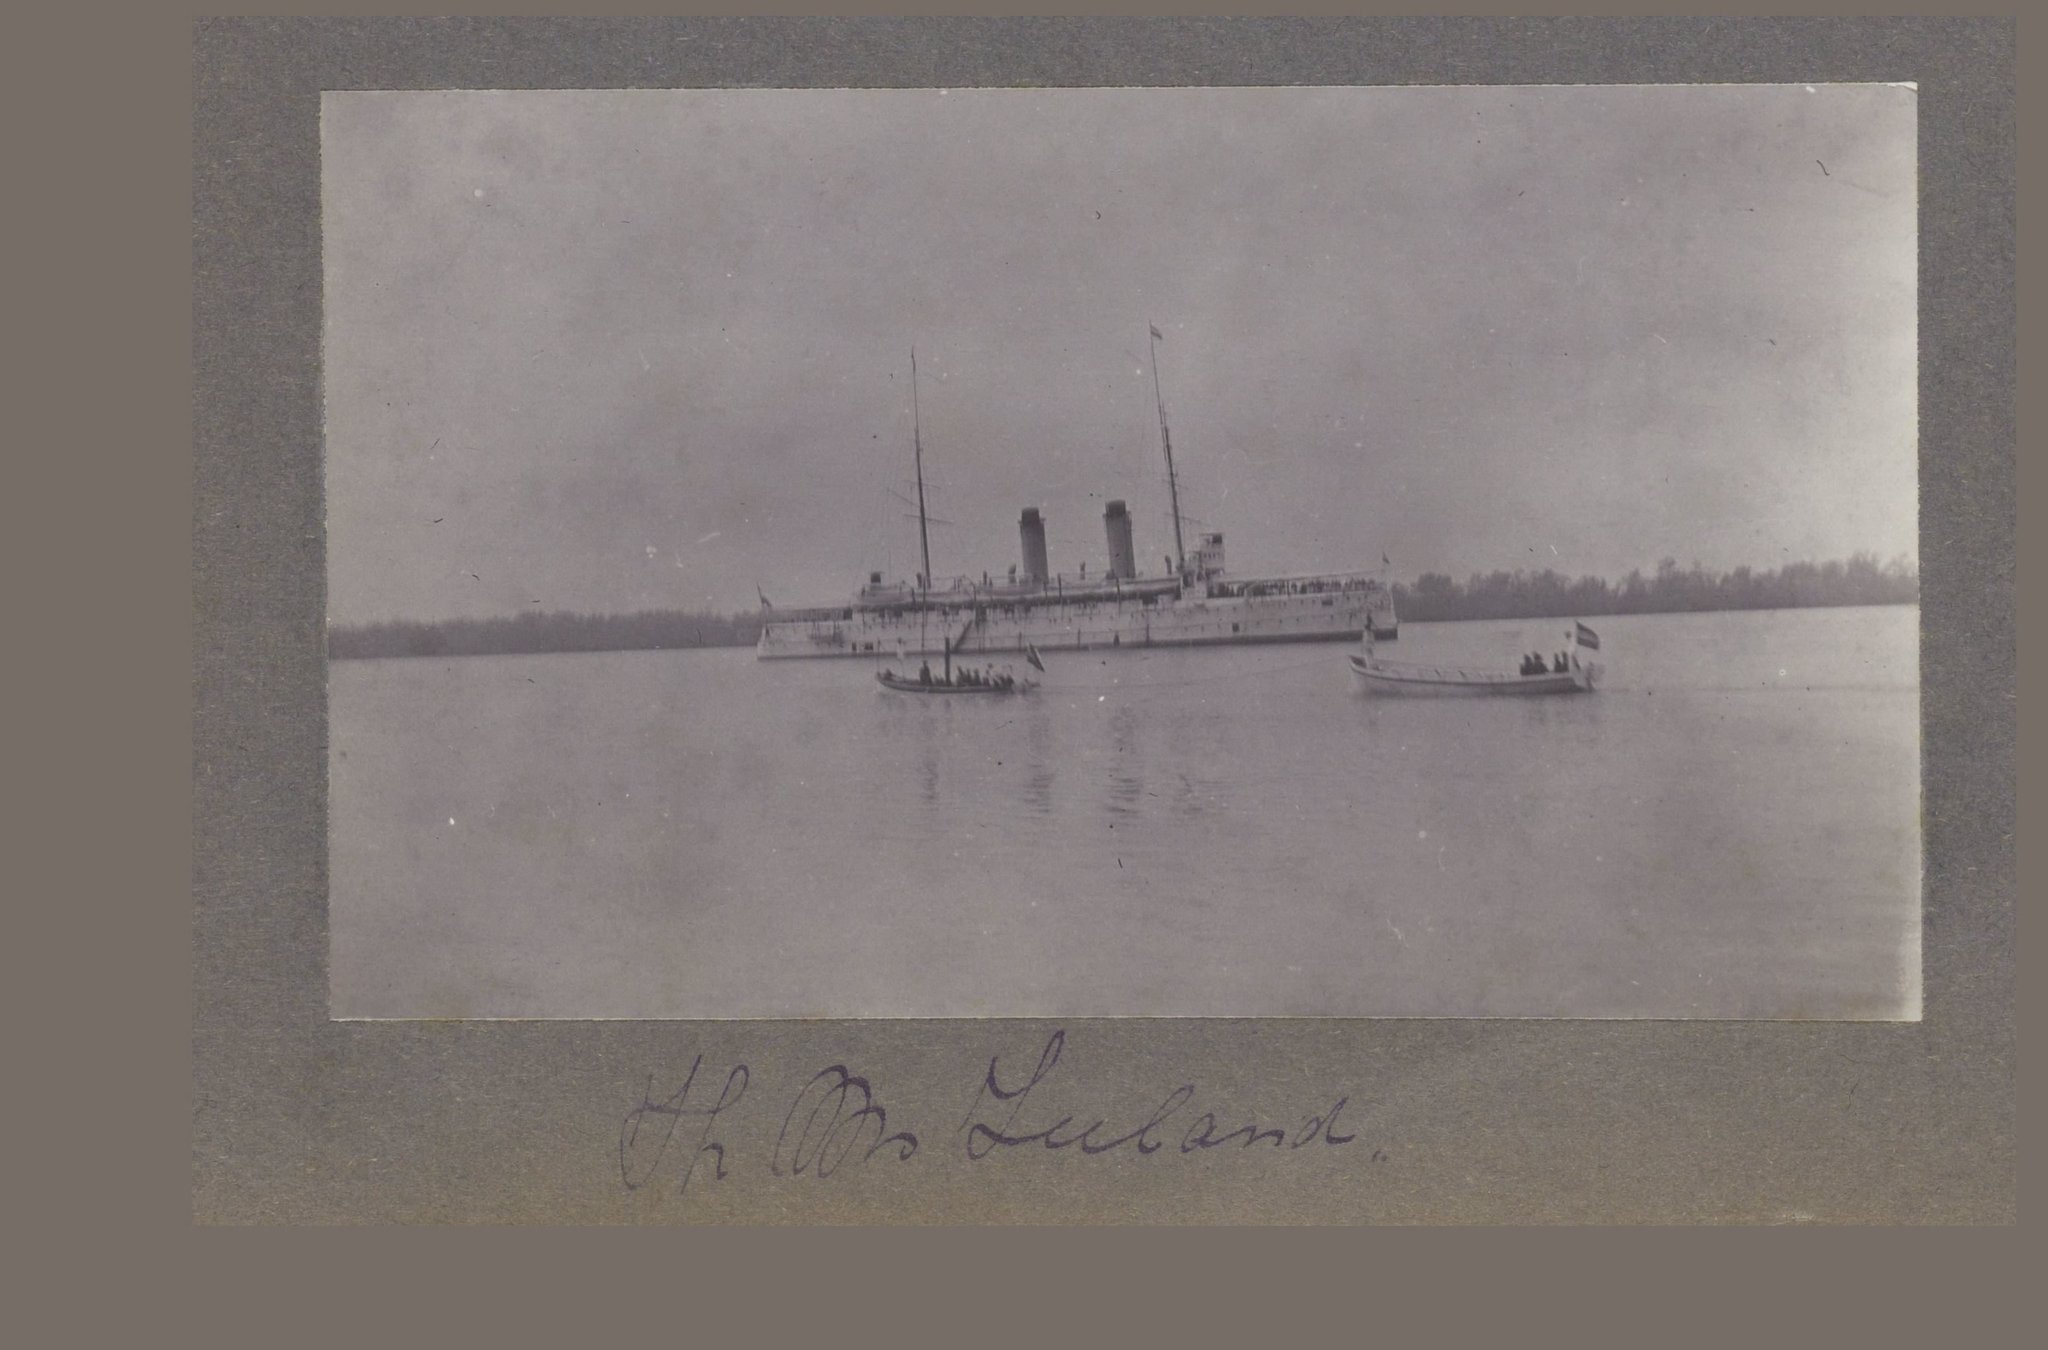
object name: photograph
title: Pantserdekschip Hr. Ms. Zeeland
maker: Anonymous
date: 1912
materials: photographic support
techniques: photography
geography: suriname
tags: navy (+ motor ships), suriname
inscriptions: inscription: ‘Hr Ms "Zeeland"’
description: Pantserdekschip Hr. Ms. Zeeland voor anker in de rivier, met twee kleine bootjes. Onderdeel van het fotoalbum over het leven van de familie Gonggrijp in Suriname rond 1912.